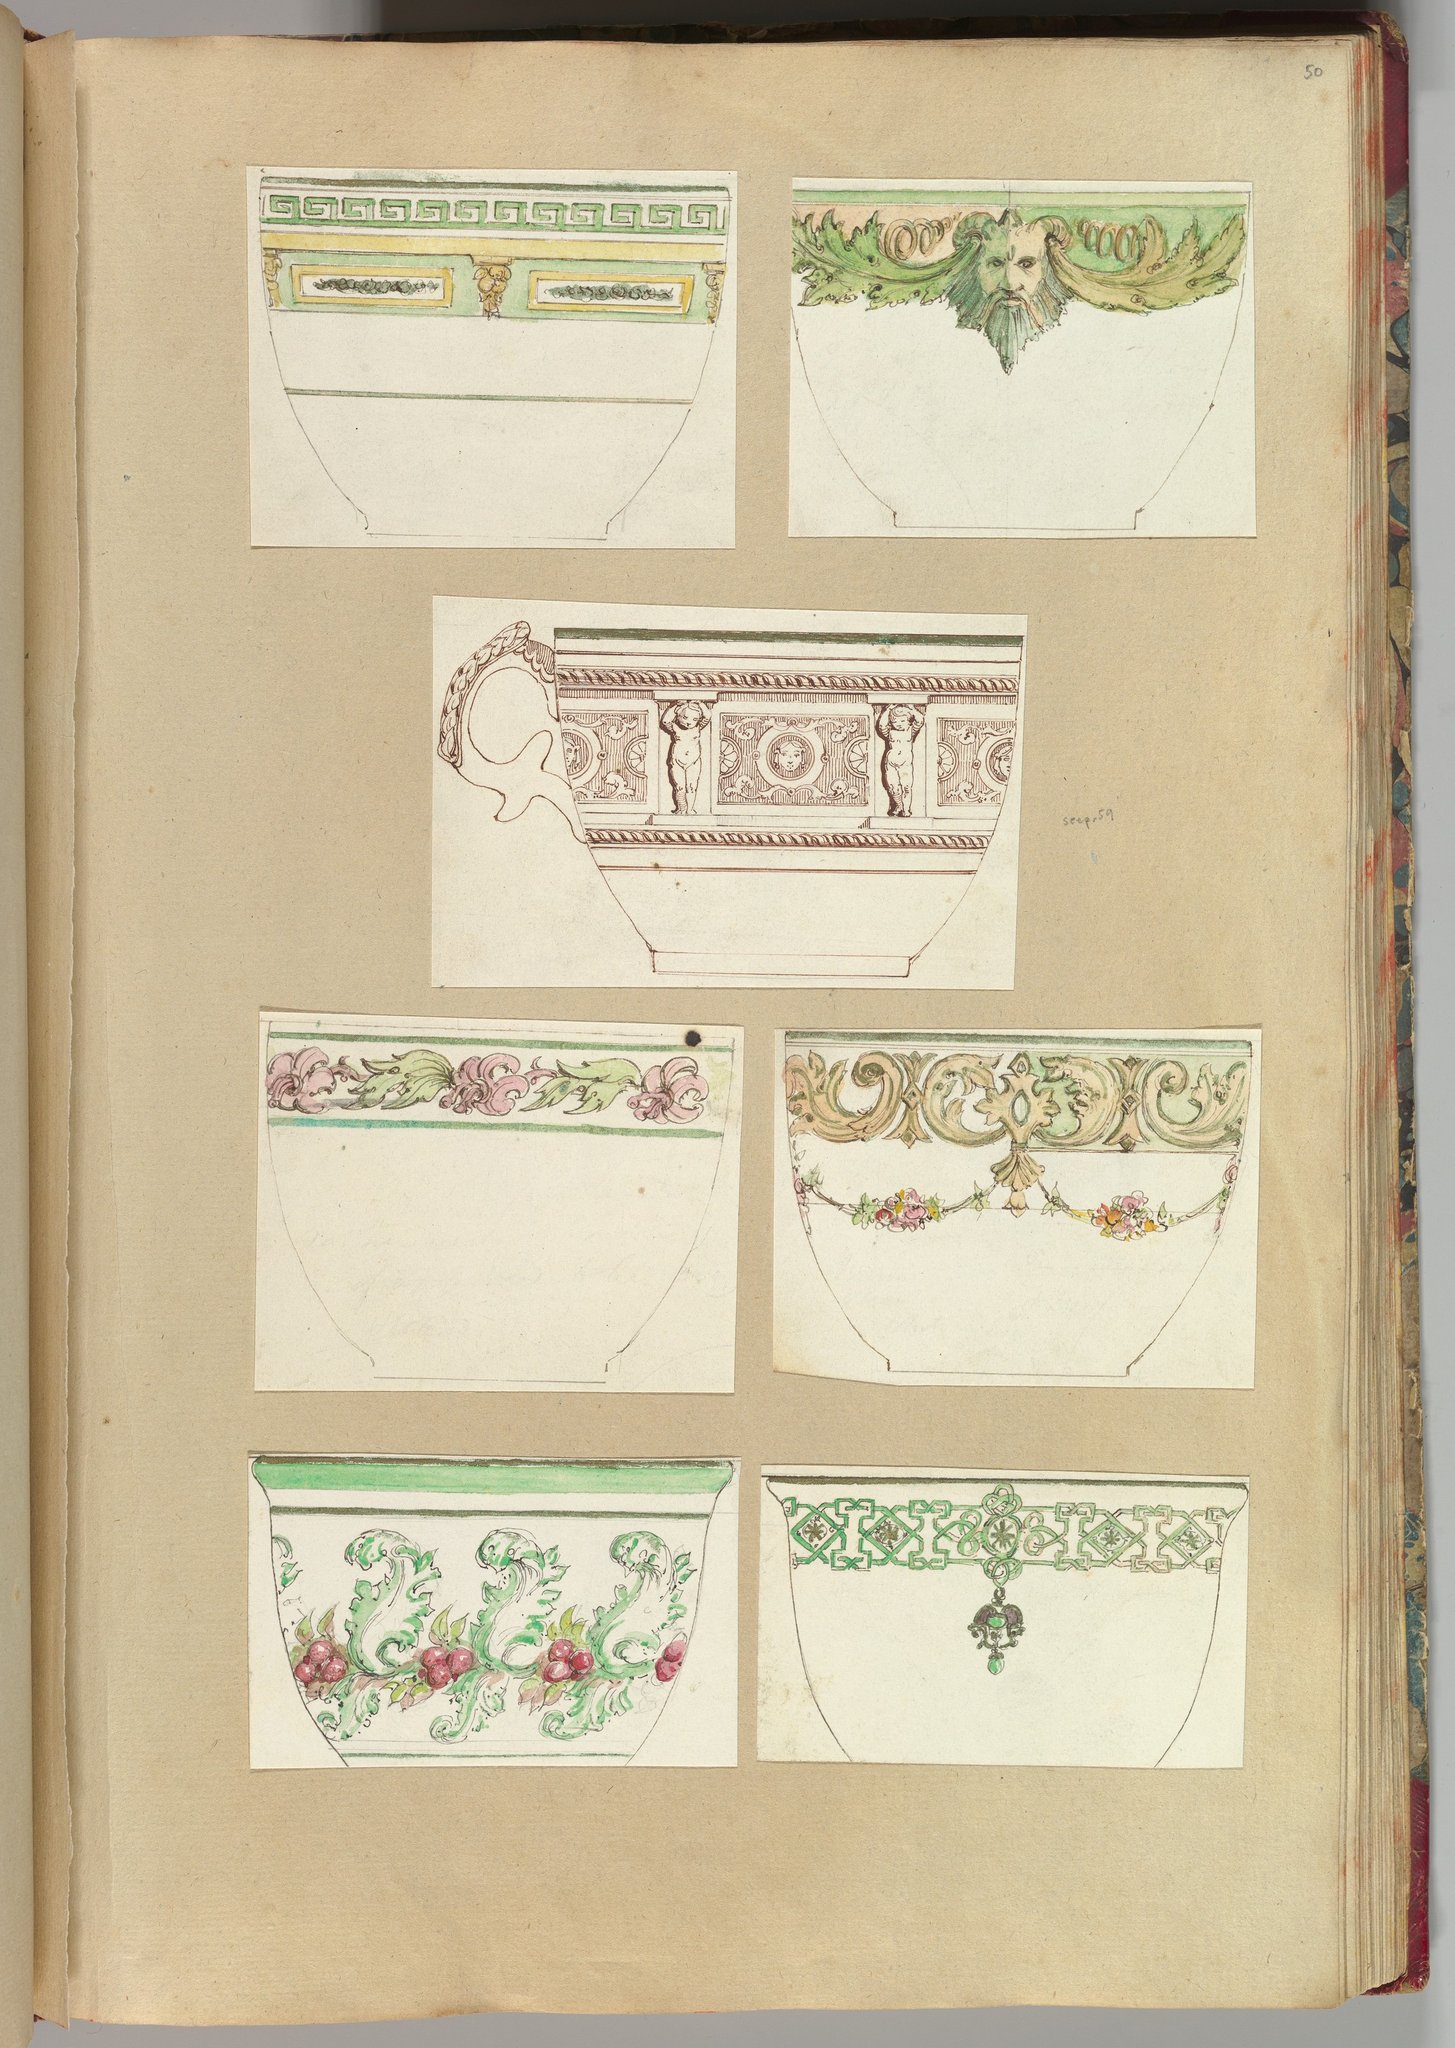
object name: drawing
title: Seven Designs for Decorated Cups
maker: alfred henry forrester [alfred crowquill]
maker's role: artist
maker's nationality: british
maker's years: 1804-1872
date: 1845-1855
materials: ink, watercolor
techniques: pen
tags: ornament,cups